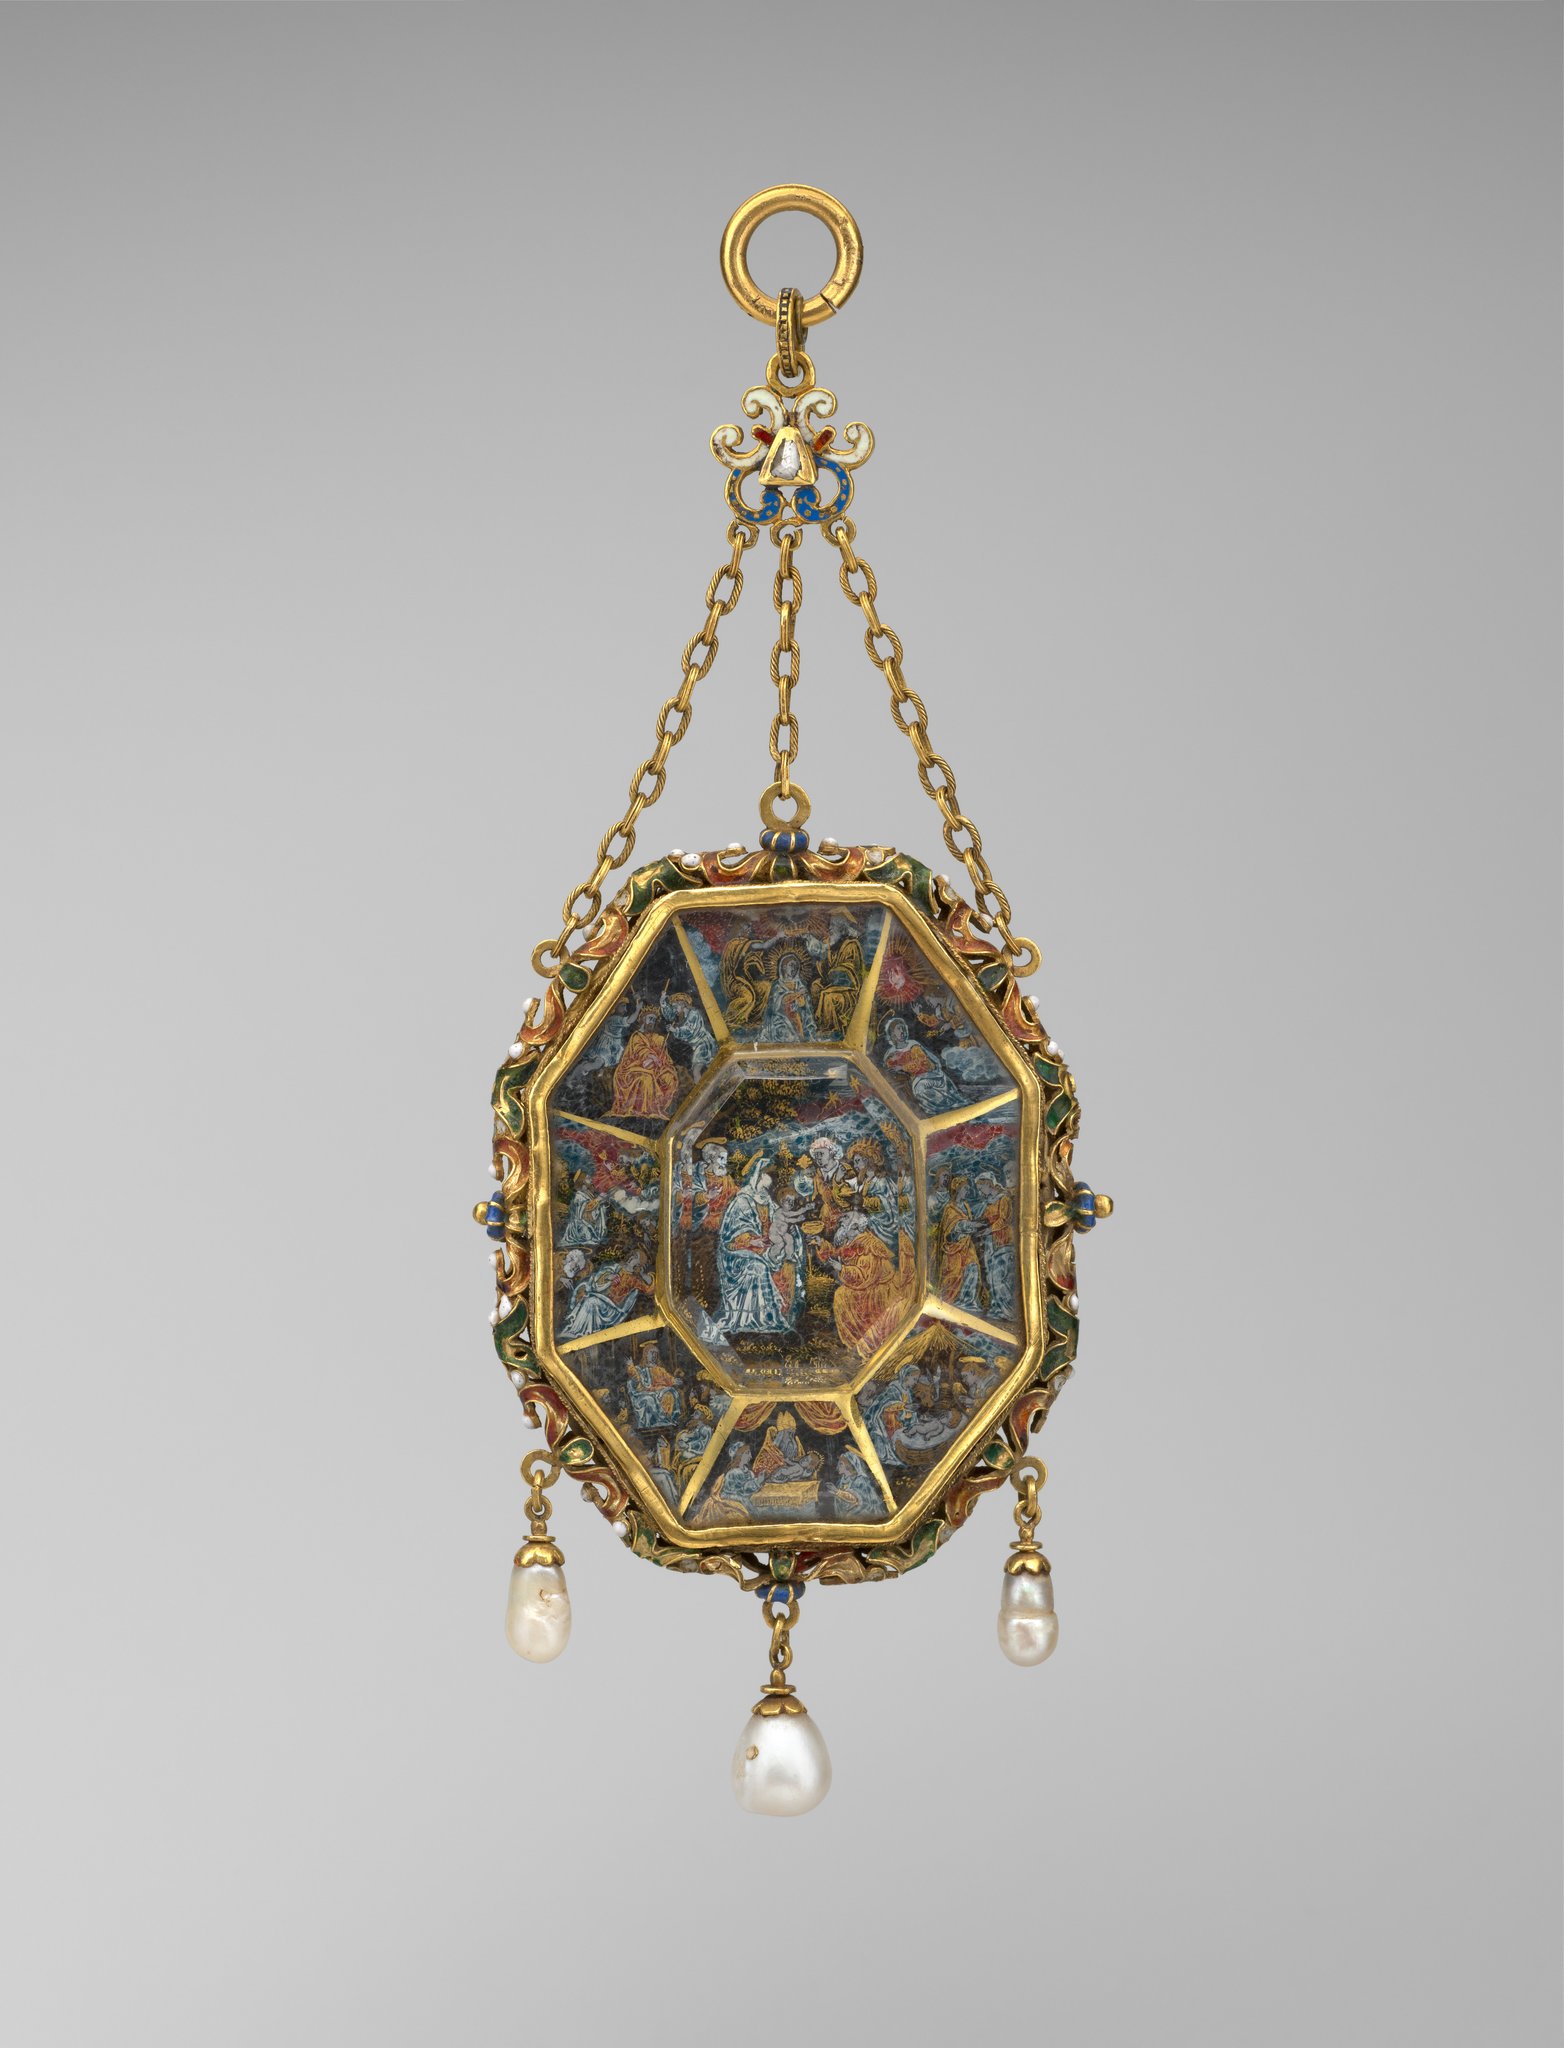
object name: pendant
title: Scenes from the Life of Christ and the Virgin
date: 1501-1525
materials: gold, pearl, quartz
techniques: enamel, painting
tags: christ,virgin mary,jesus